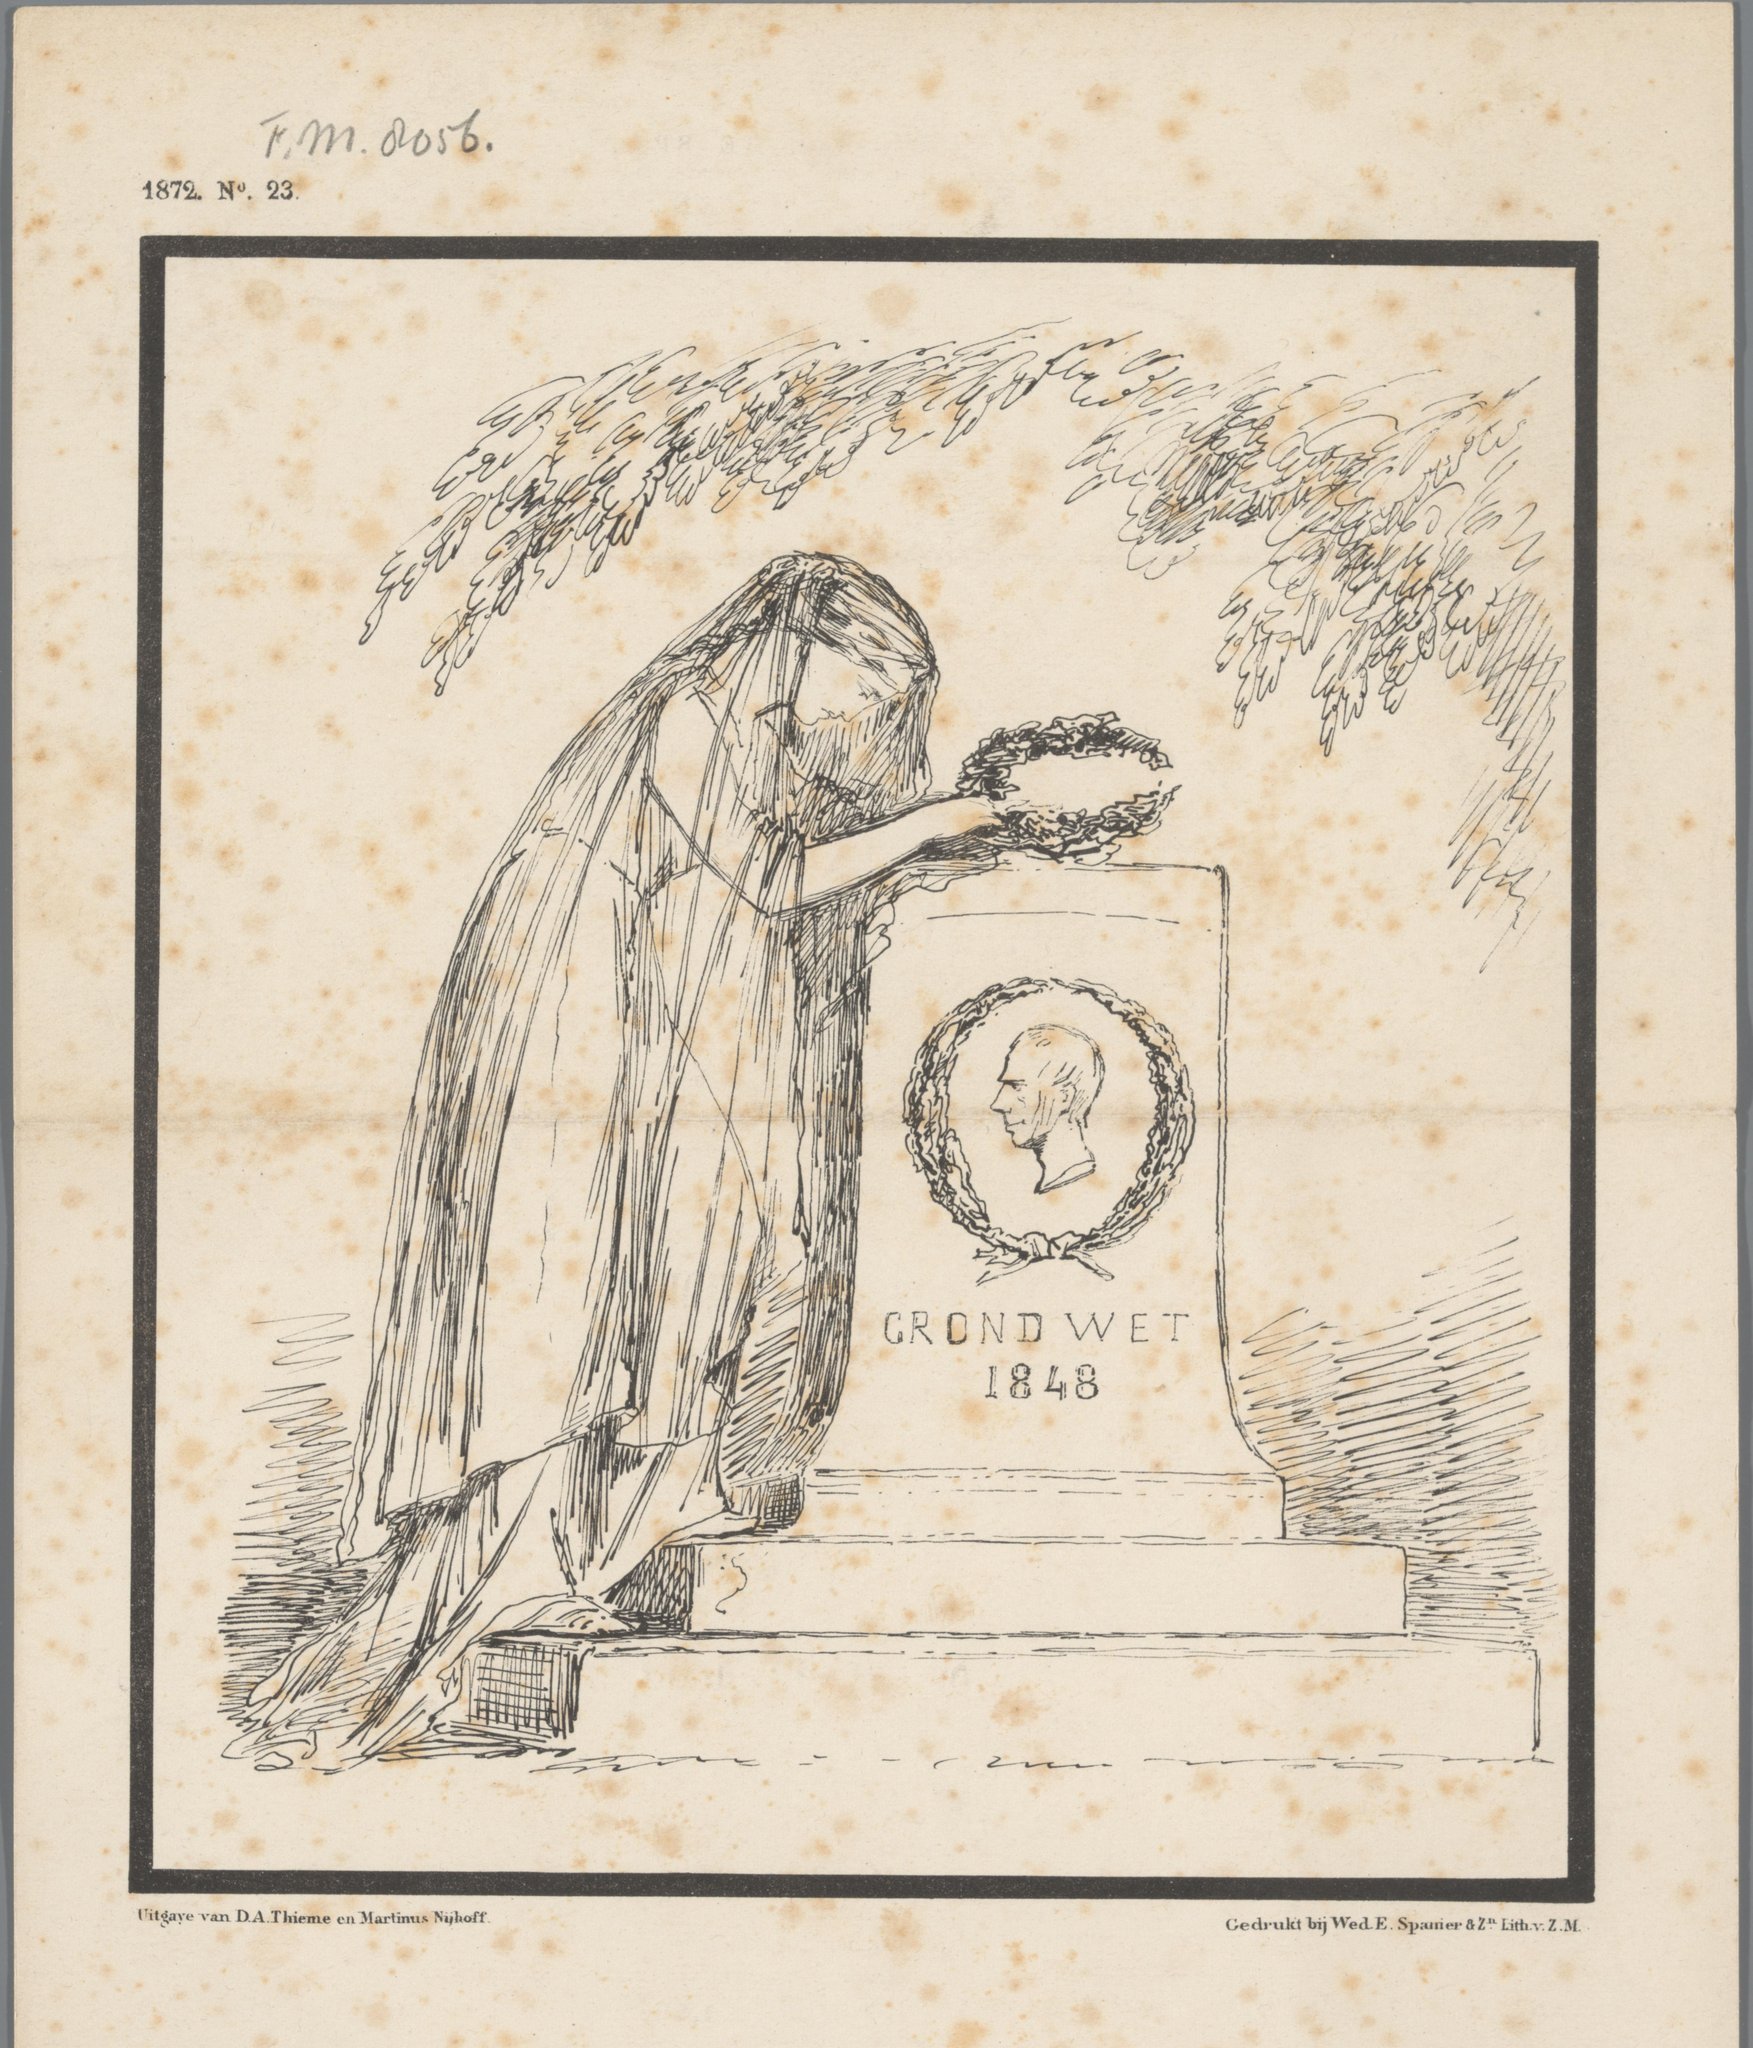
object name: print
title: Allegorie op het overlijden van Thorbecke, 1872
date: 1872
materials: paper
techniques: lithograph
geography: arnhem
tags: johan rudolf thorbecke, personifications of countries, nations, states, districts, etc., grave-building, monumental tomb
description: Allegorie op het overlijden van Thorbecke, 4 juni 1872. De Nederlandse Maagd in rouw legt een krans op het grafmonument van Thorbecke waarop de inscripte 'Grondwet 1848'. Plaat verschenen bij het weekblad De Nederlandsche Spectator, nr. 23, 1872.